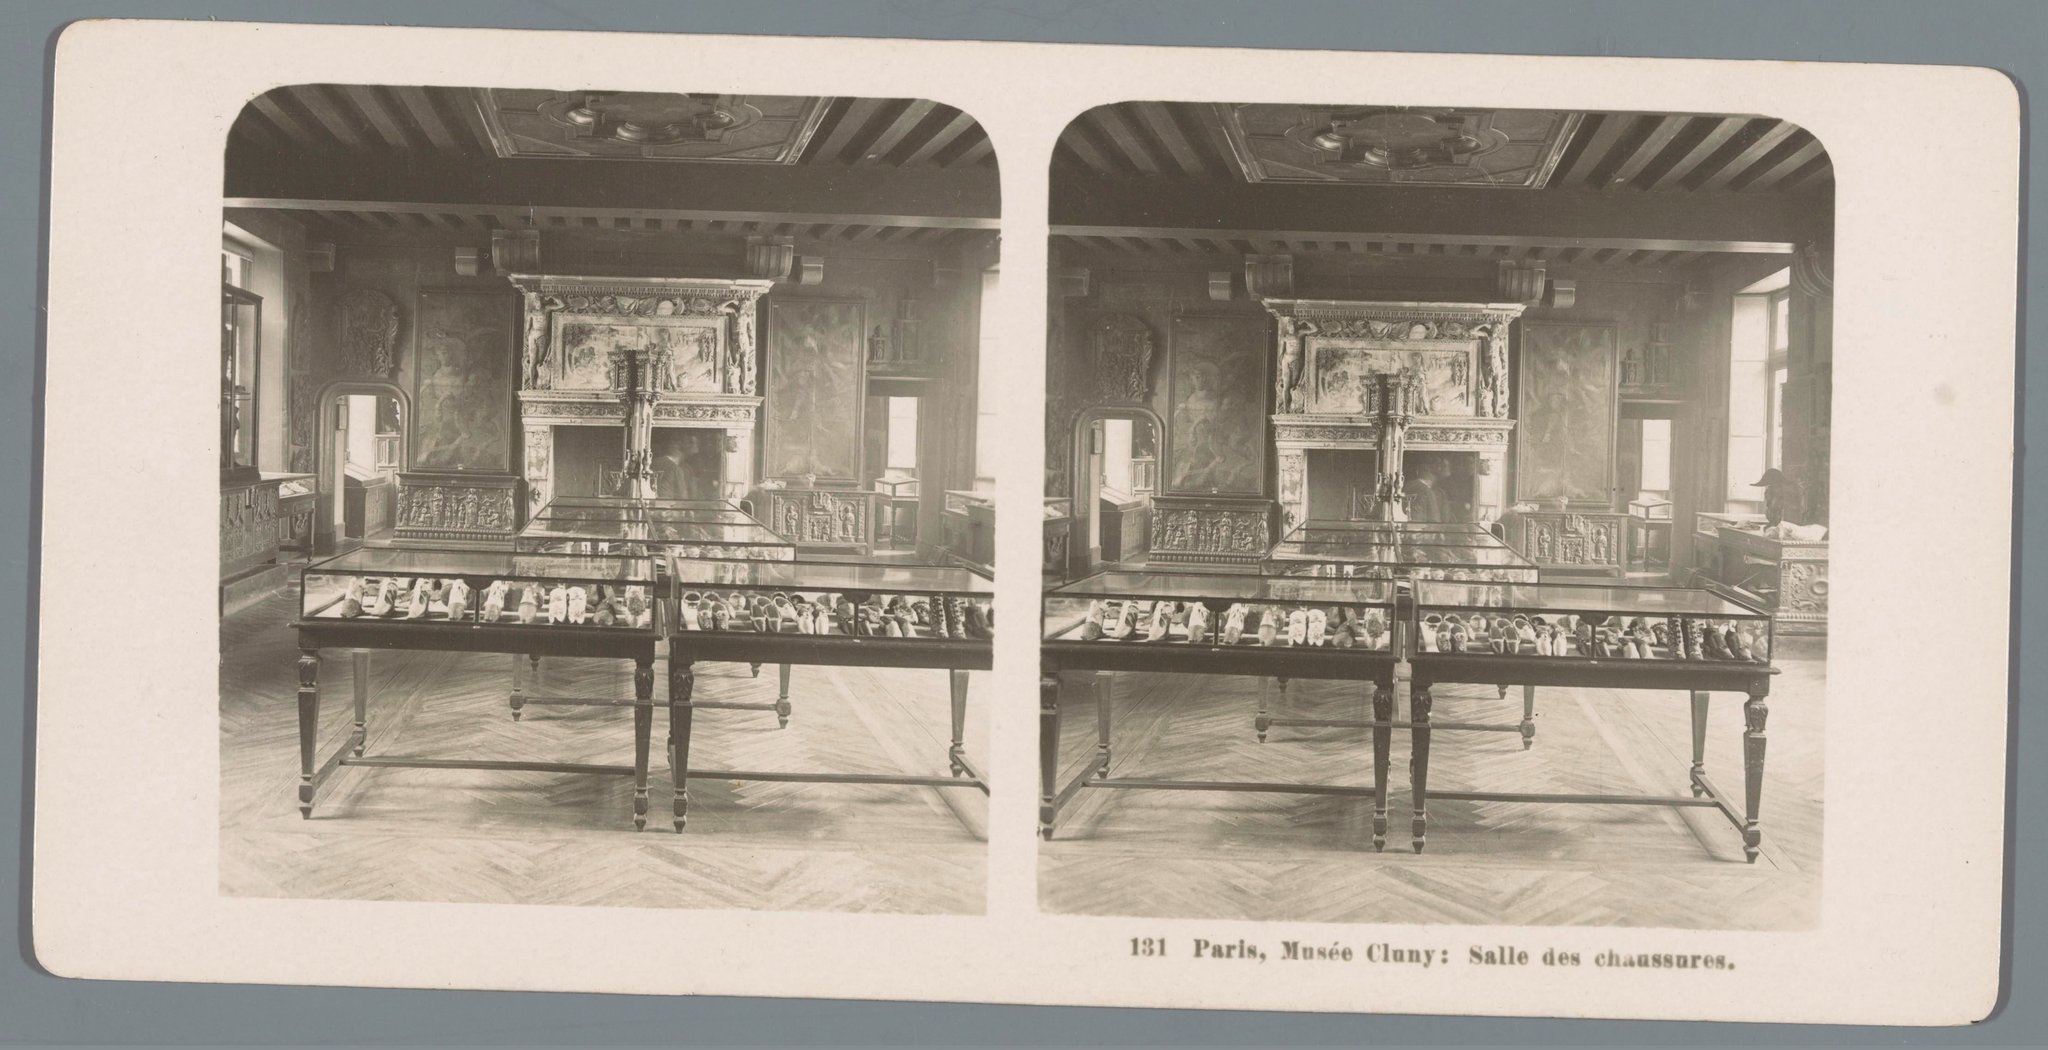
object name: stereograph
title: Paris, Musée Cluny: Salle des chaussures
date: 1902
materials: cardboard, photographic support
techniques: gelatin silver print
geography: musée de cluny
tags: shoes, sandals, permanent exhibition, museum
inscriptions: number: ‘131’, inscription: ‘Neue Photographische Gesellschaft A.-G. Steglitz-Berlin 1902.’